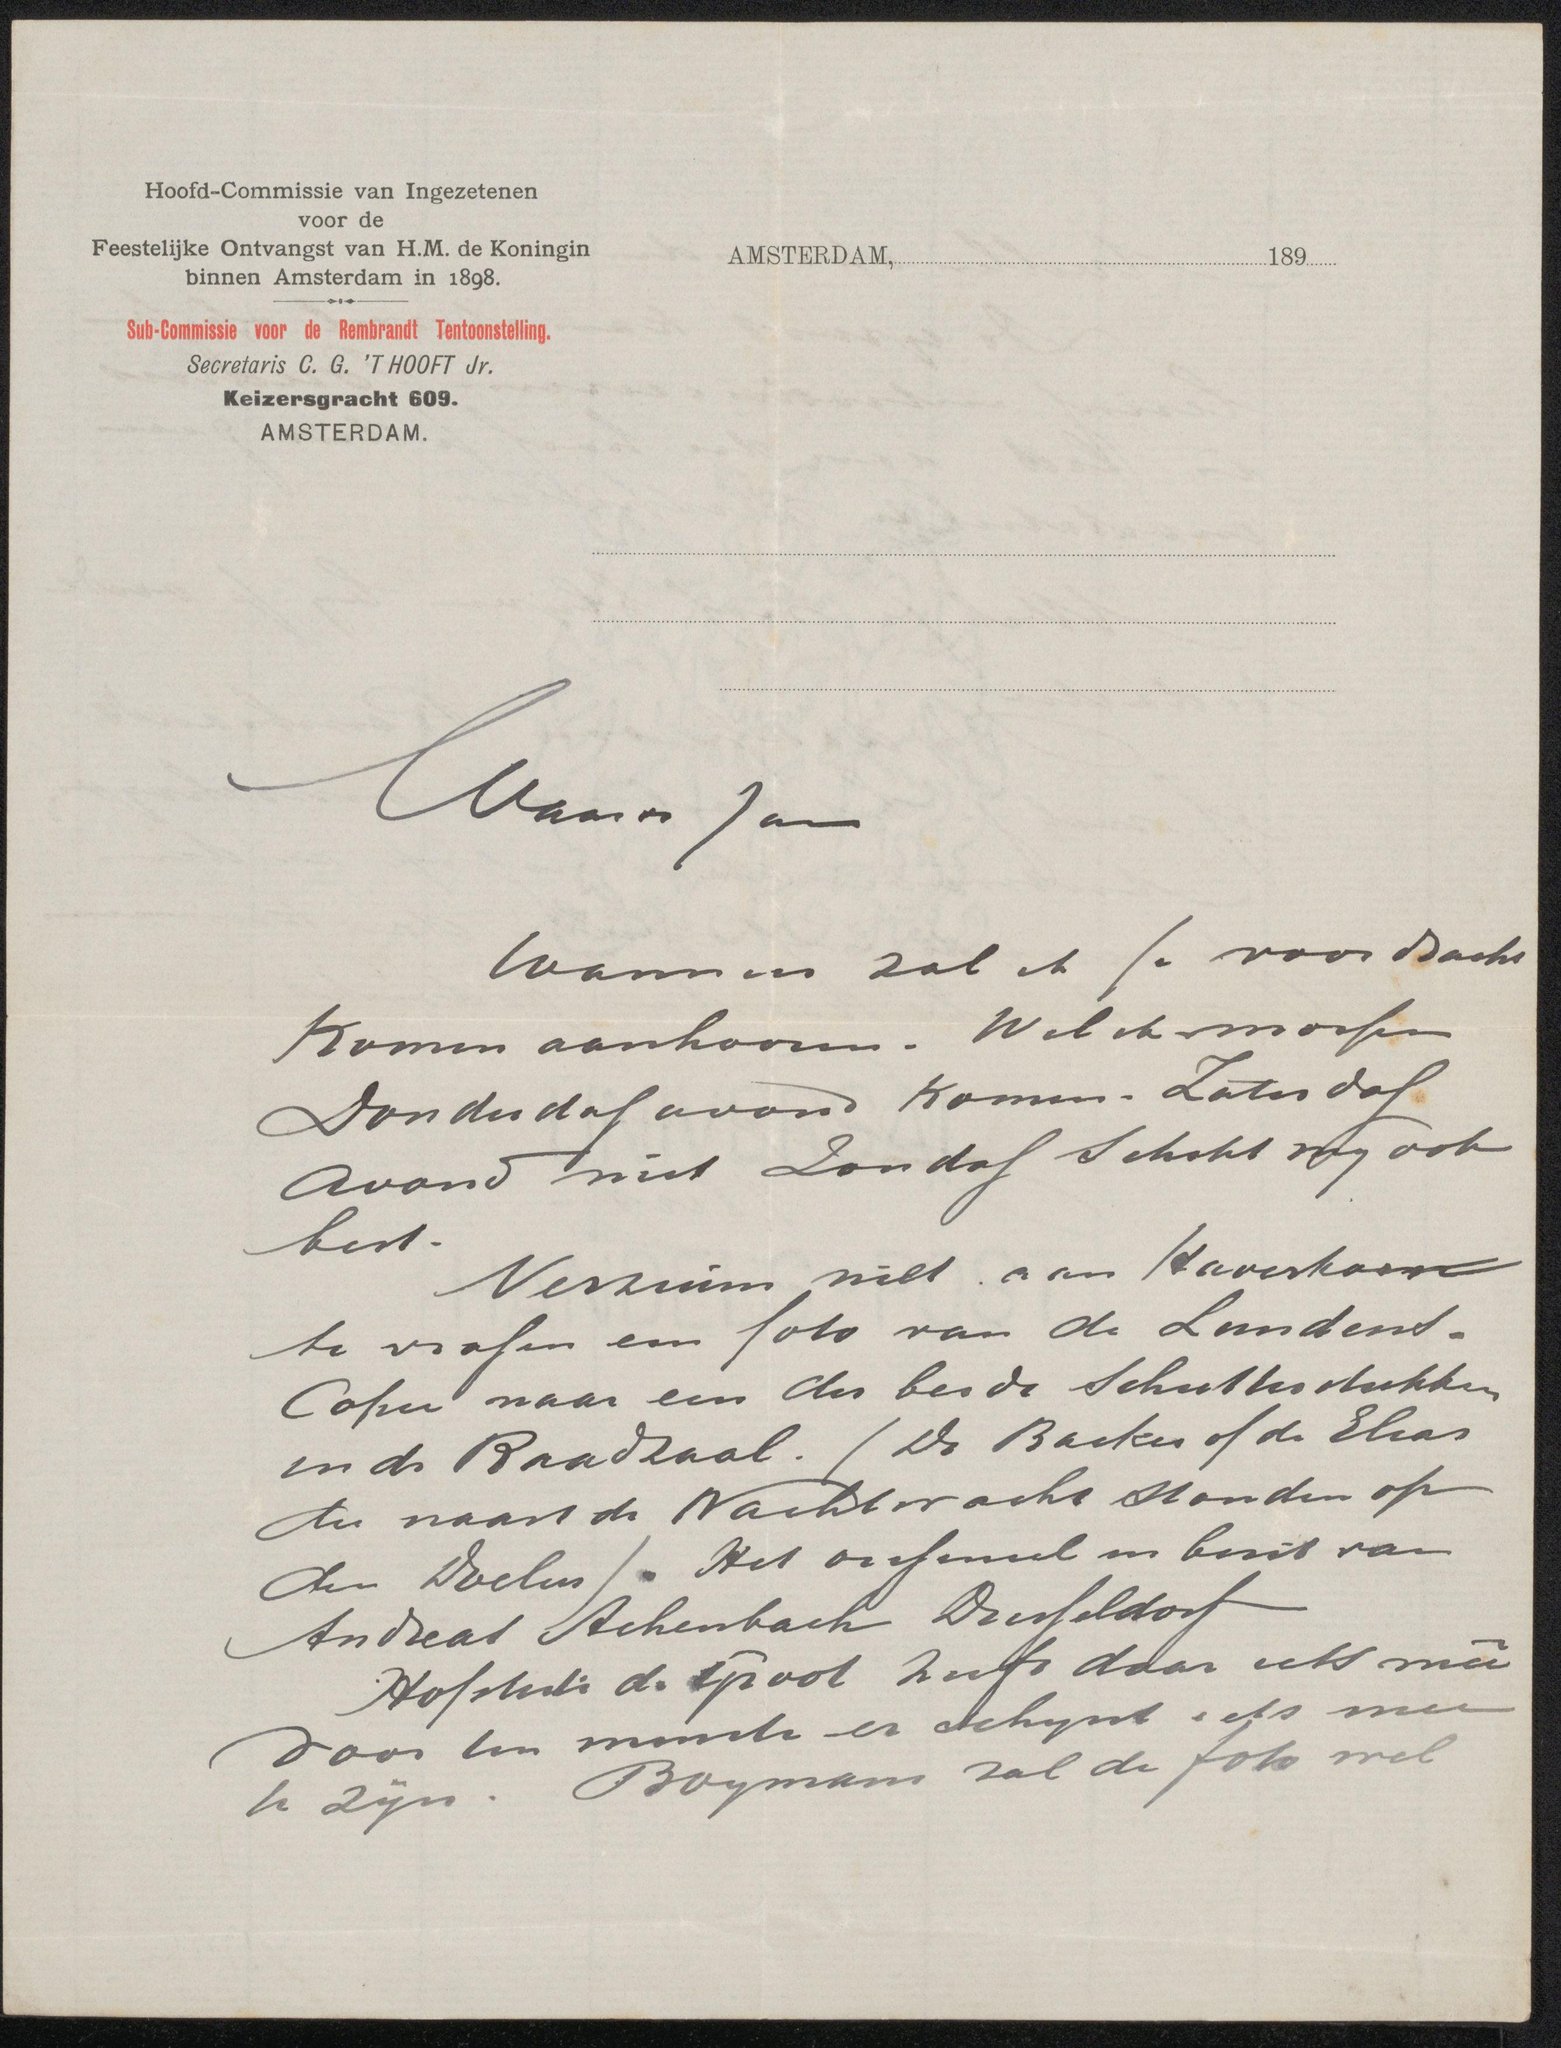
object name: letter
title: Brief aan Jan Veth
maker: cornelis gerardus t hooft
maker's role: draughtsman, painter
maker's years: 1866-1936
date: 1890-1899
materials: ink, paper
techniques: pen, printing, writing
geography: amsterdam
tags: andreas achenbach, harlingen, jacob adriaensz backer, print maker, designer, jan veth, nicolaes eliasz pickenoy, leiden, rembrandt van rijn, abraham bredius, the hague, cornelis hofstede de groot, photography, cinematography, painting (including book-illumination, miniature-painting)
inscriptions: collector's mark: ‘RPK’